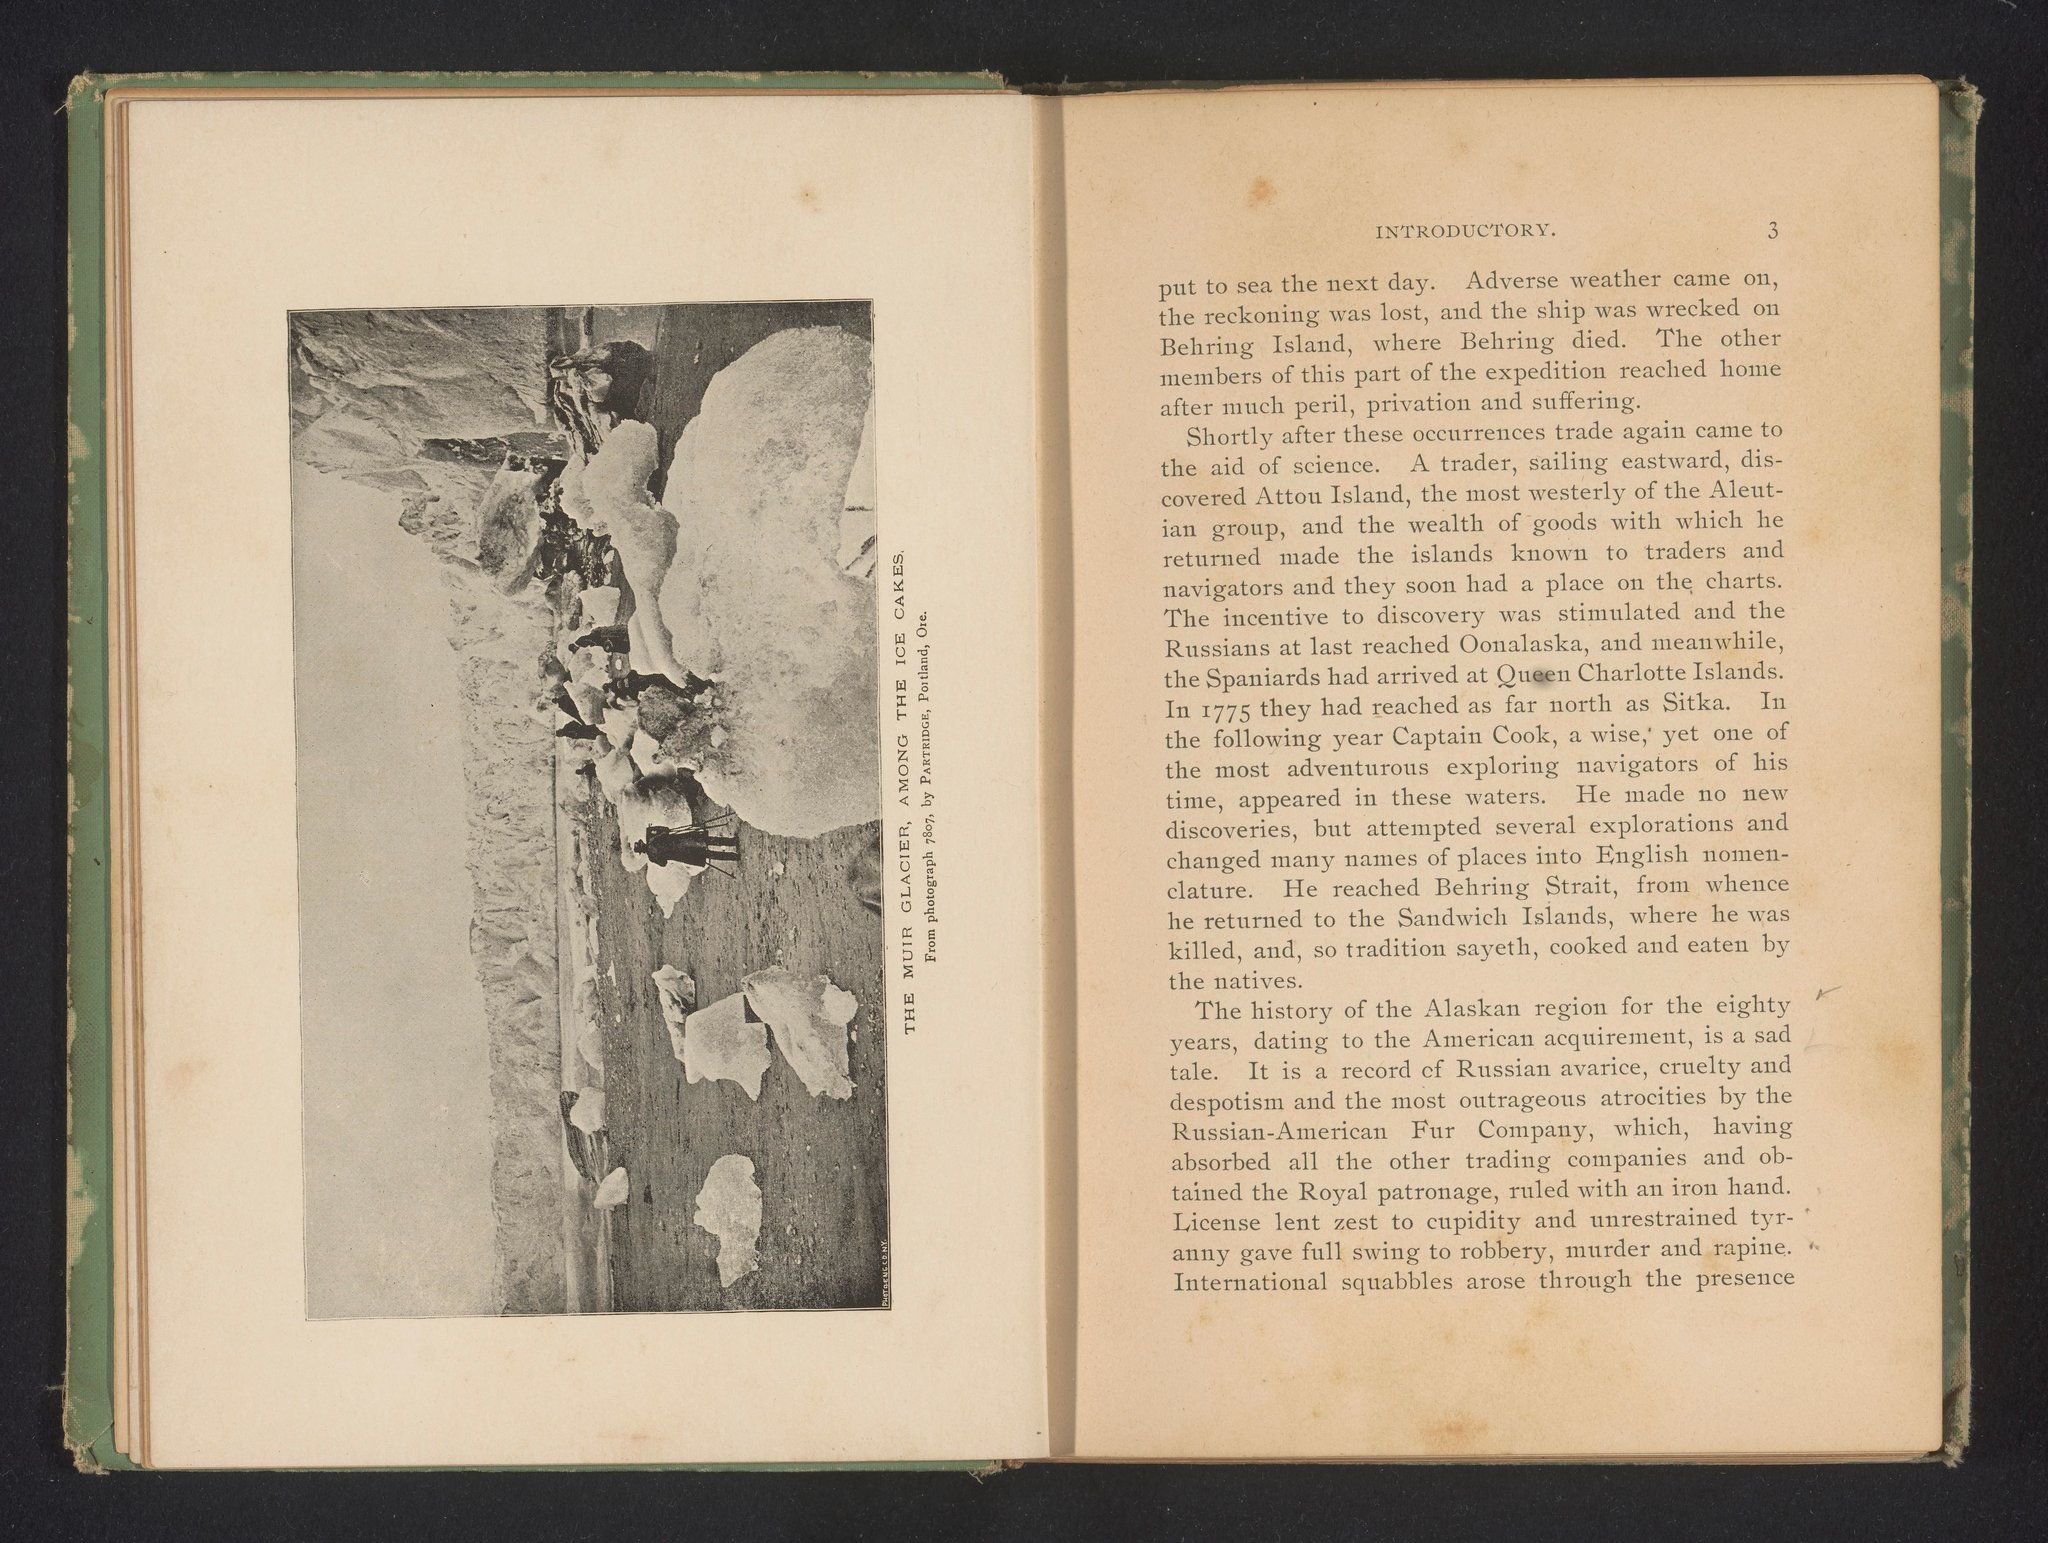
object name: page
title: The Muir glacier, among the ice cakes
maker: william henry partridge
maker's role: fotograaf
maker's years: 1858-1939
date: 1885-1890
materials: paper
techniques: autotype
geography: skagway-hoonah-angoon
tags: glacier, anonymous historical persons portrayed in a group, in a group-portrait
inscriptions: inscription: ‘From photograph 7807, by Partridge, Portland, Ore’